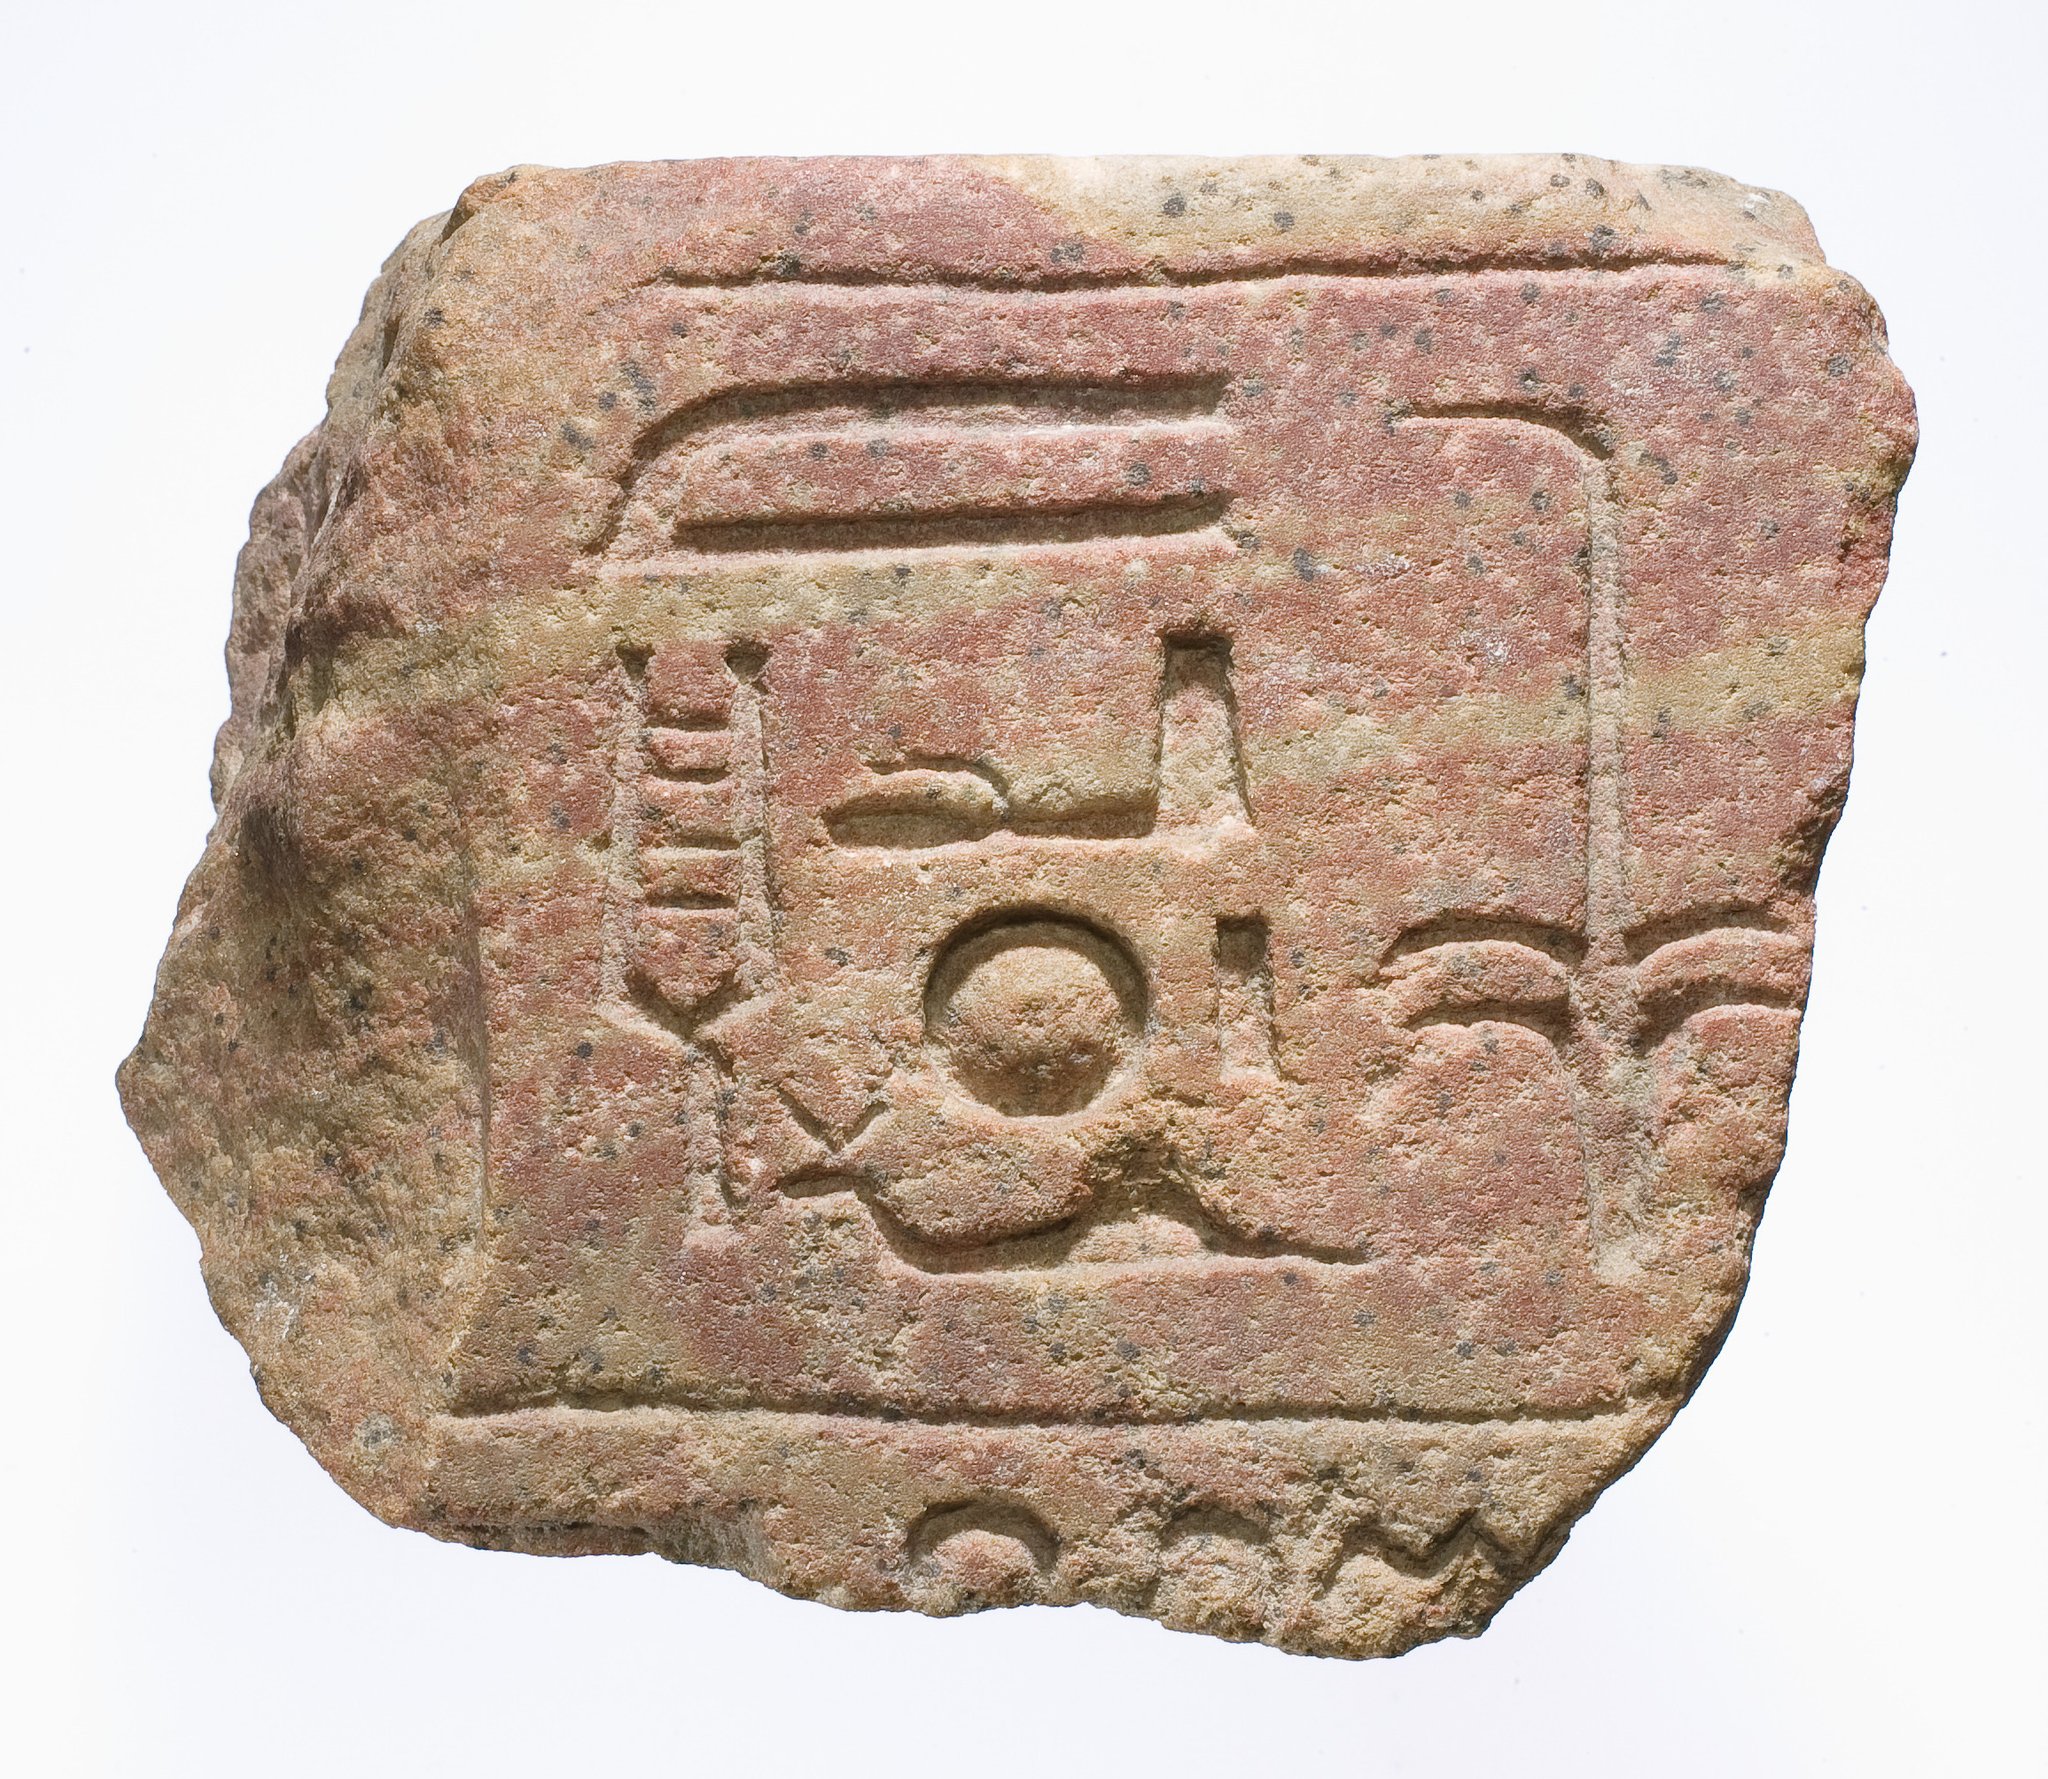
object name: edge of a block, epithet of king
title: Block fragment inscribed with epithets of the king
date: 1353-1336 BCE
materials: quartzite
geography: egypt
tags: hieroglyphs